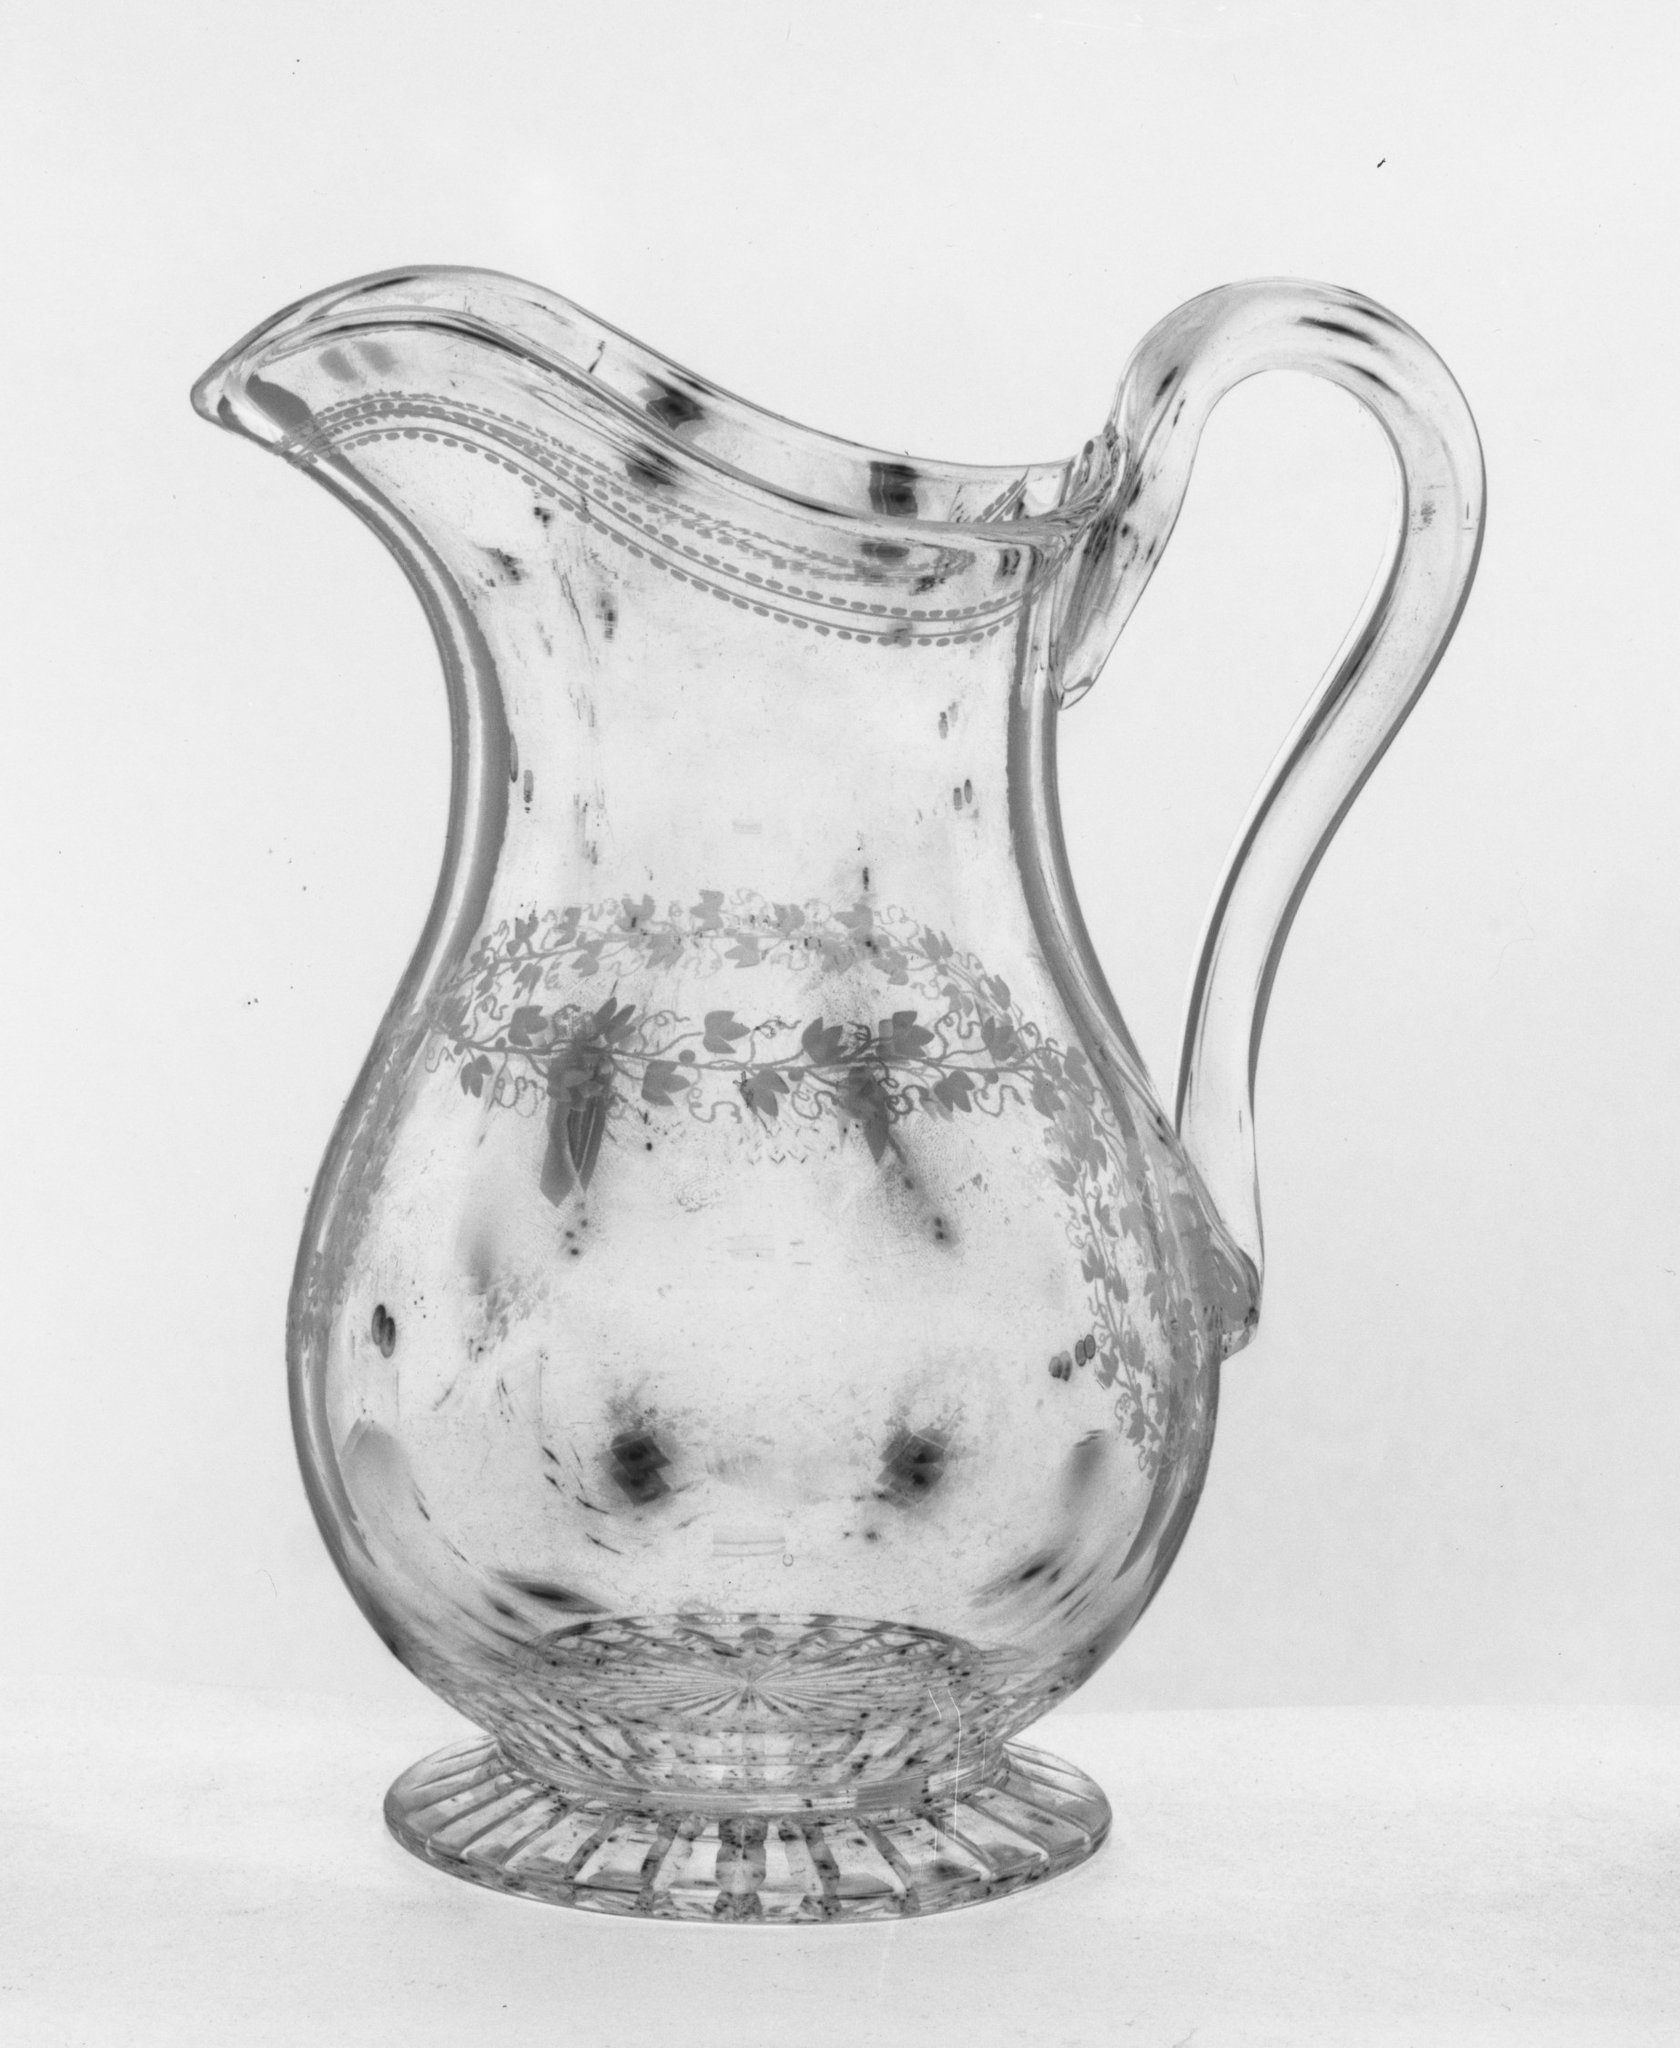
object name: pitcher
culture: american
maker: boston & sandwich glass company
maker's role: maker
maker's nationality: american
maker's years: 1825-1888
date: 1867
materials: glass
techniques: glassblowing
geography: united states